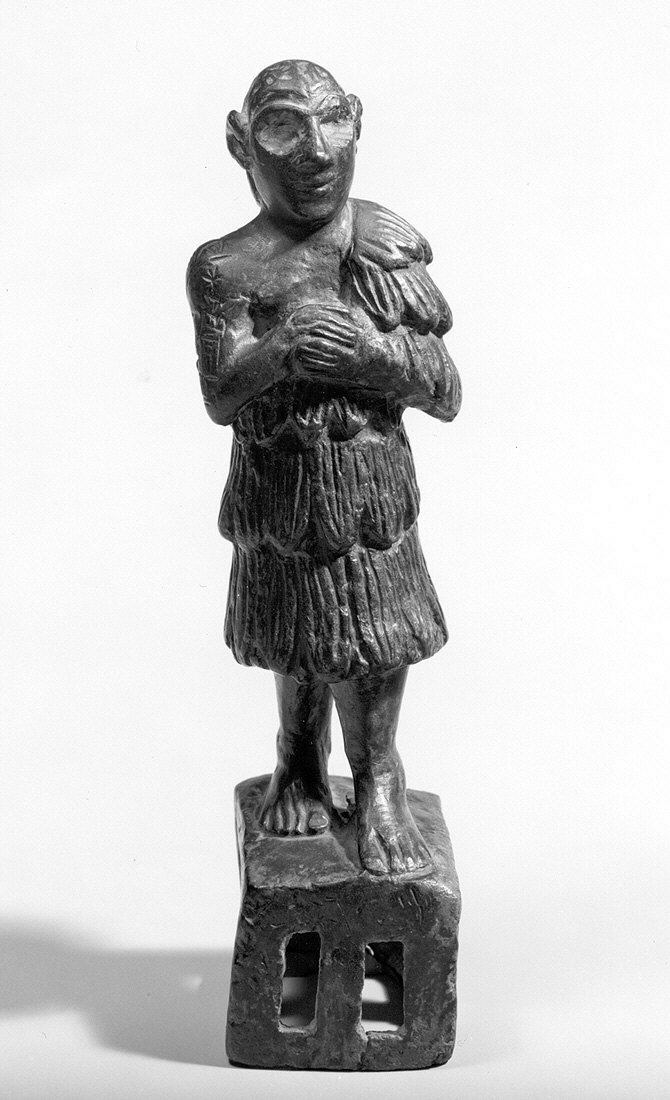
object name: sculpture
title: Standing male worshiper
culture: sumerian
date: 2500-2350 BCE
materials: copper alloy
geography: mesopotamia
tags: men